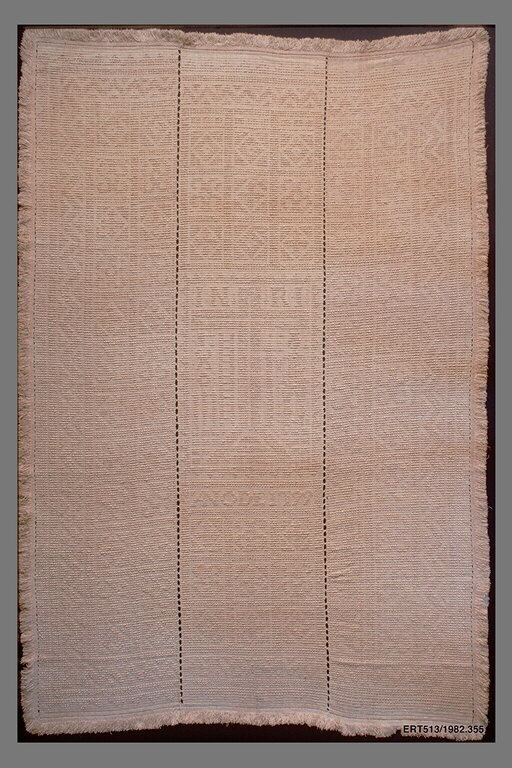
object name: hanging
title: Hanging with Instruments of the Passion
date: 1799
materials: linen